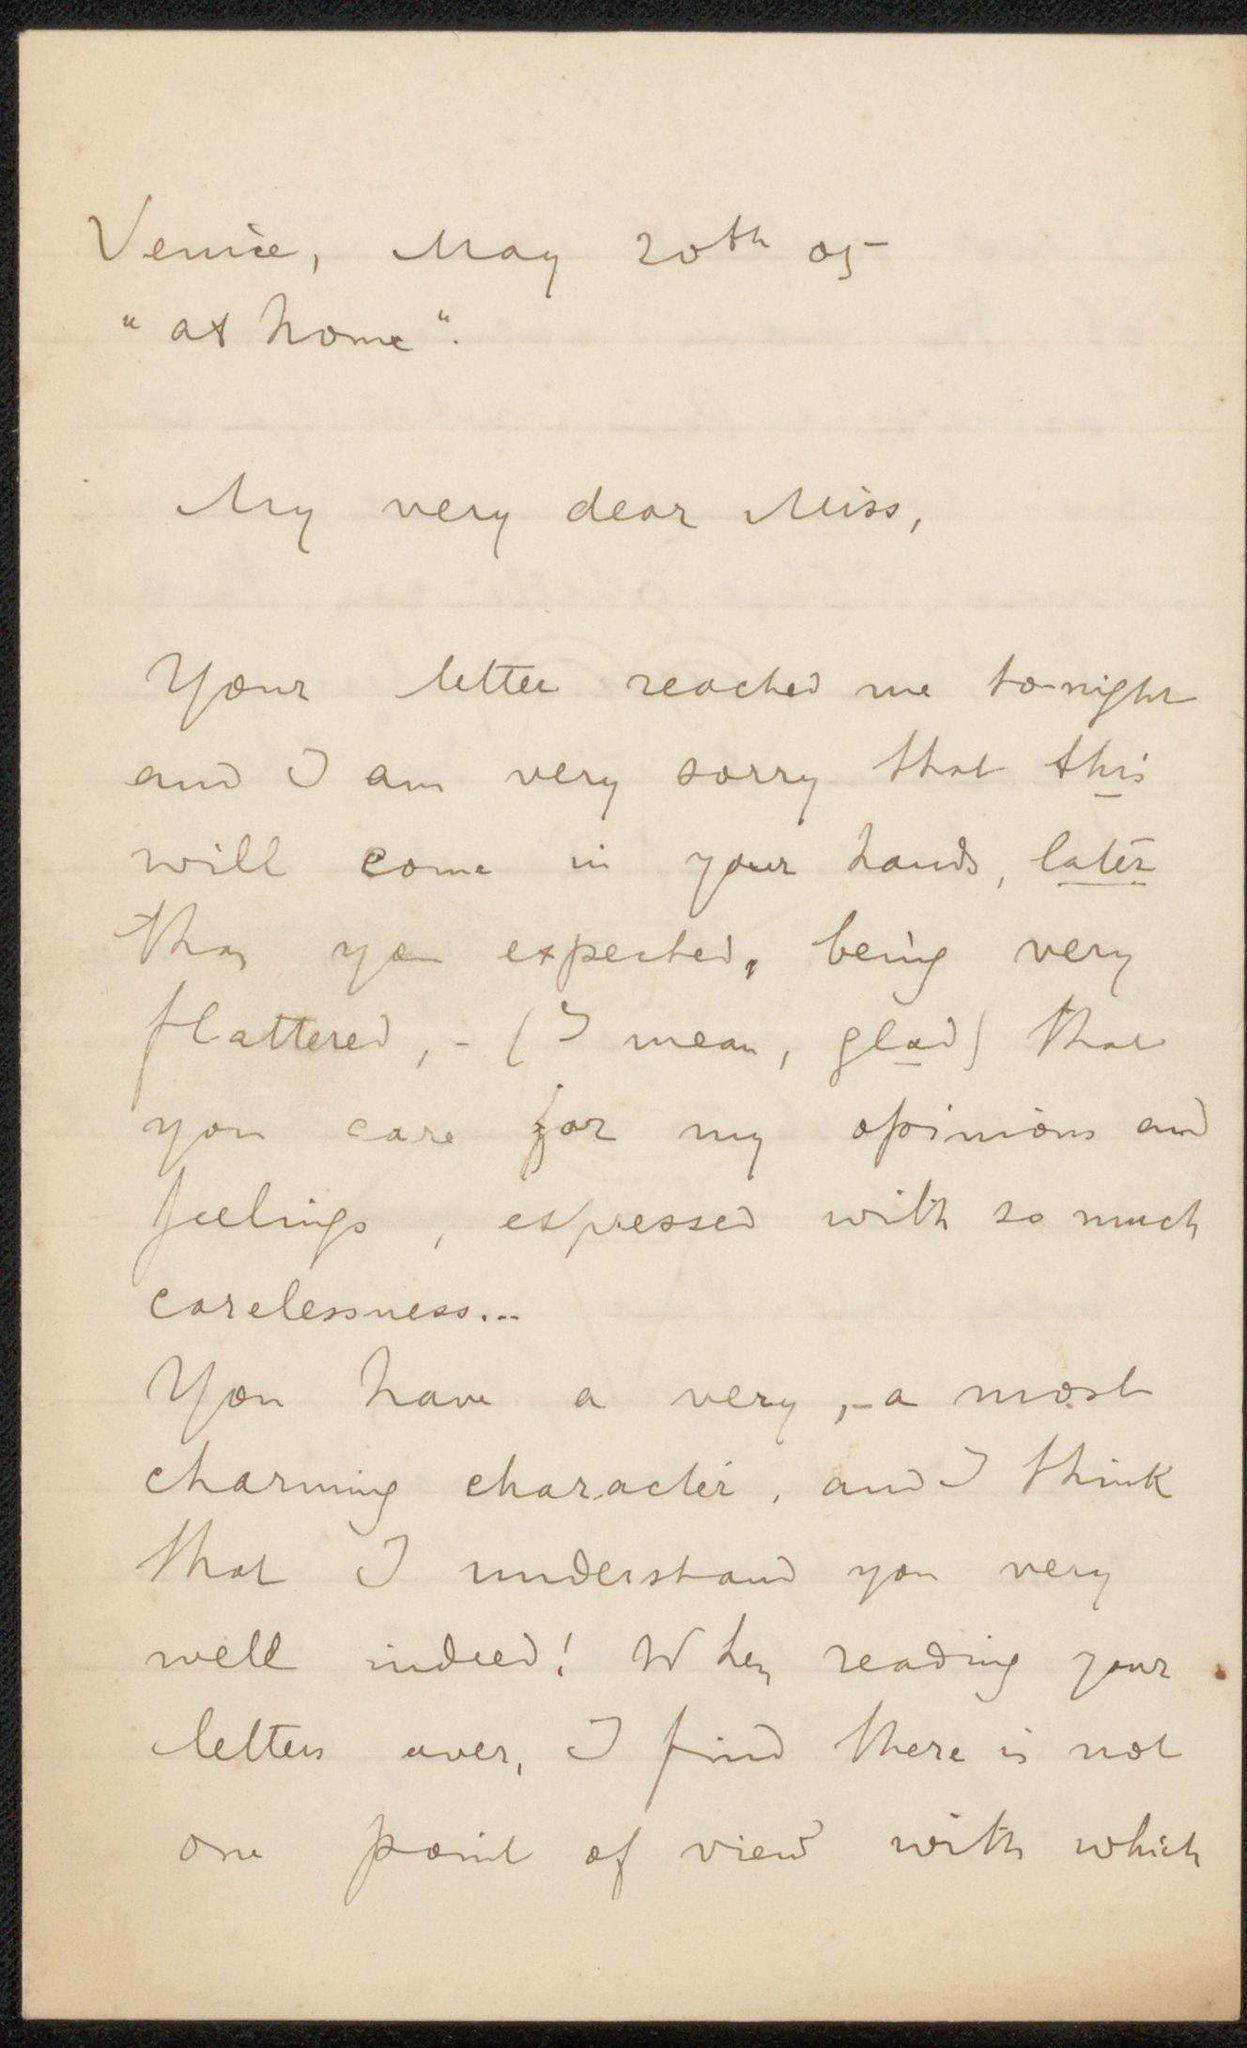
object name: letter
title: Brief aan Elsie Maud Cownie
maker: philip zilcken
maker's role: draughtsman, painter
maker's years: 1857-1930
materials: ink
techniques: pen, writing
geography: venice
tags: voorburg, print maker, renée hélène laure zilcken, manchester, the hague, draughtsman, elsie maud cownie, drawing, the graphic arts, family life, education, tuition of the artist (in general), painting (including book-illumination, miniature-painting), artist at work, in his workshop - bb - out of doors, money, paris, venice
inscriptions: watermark